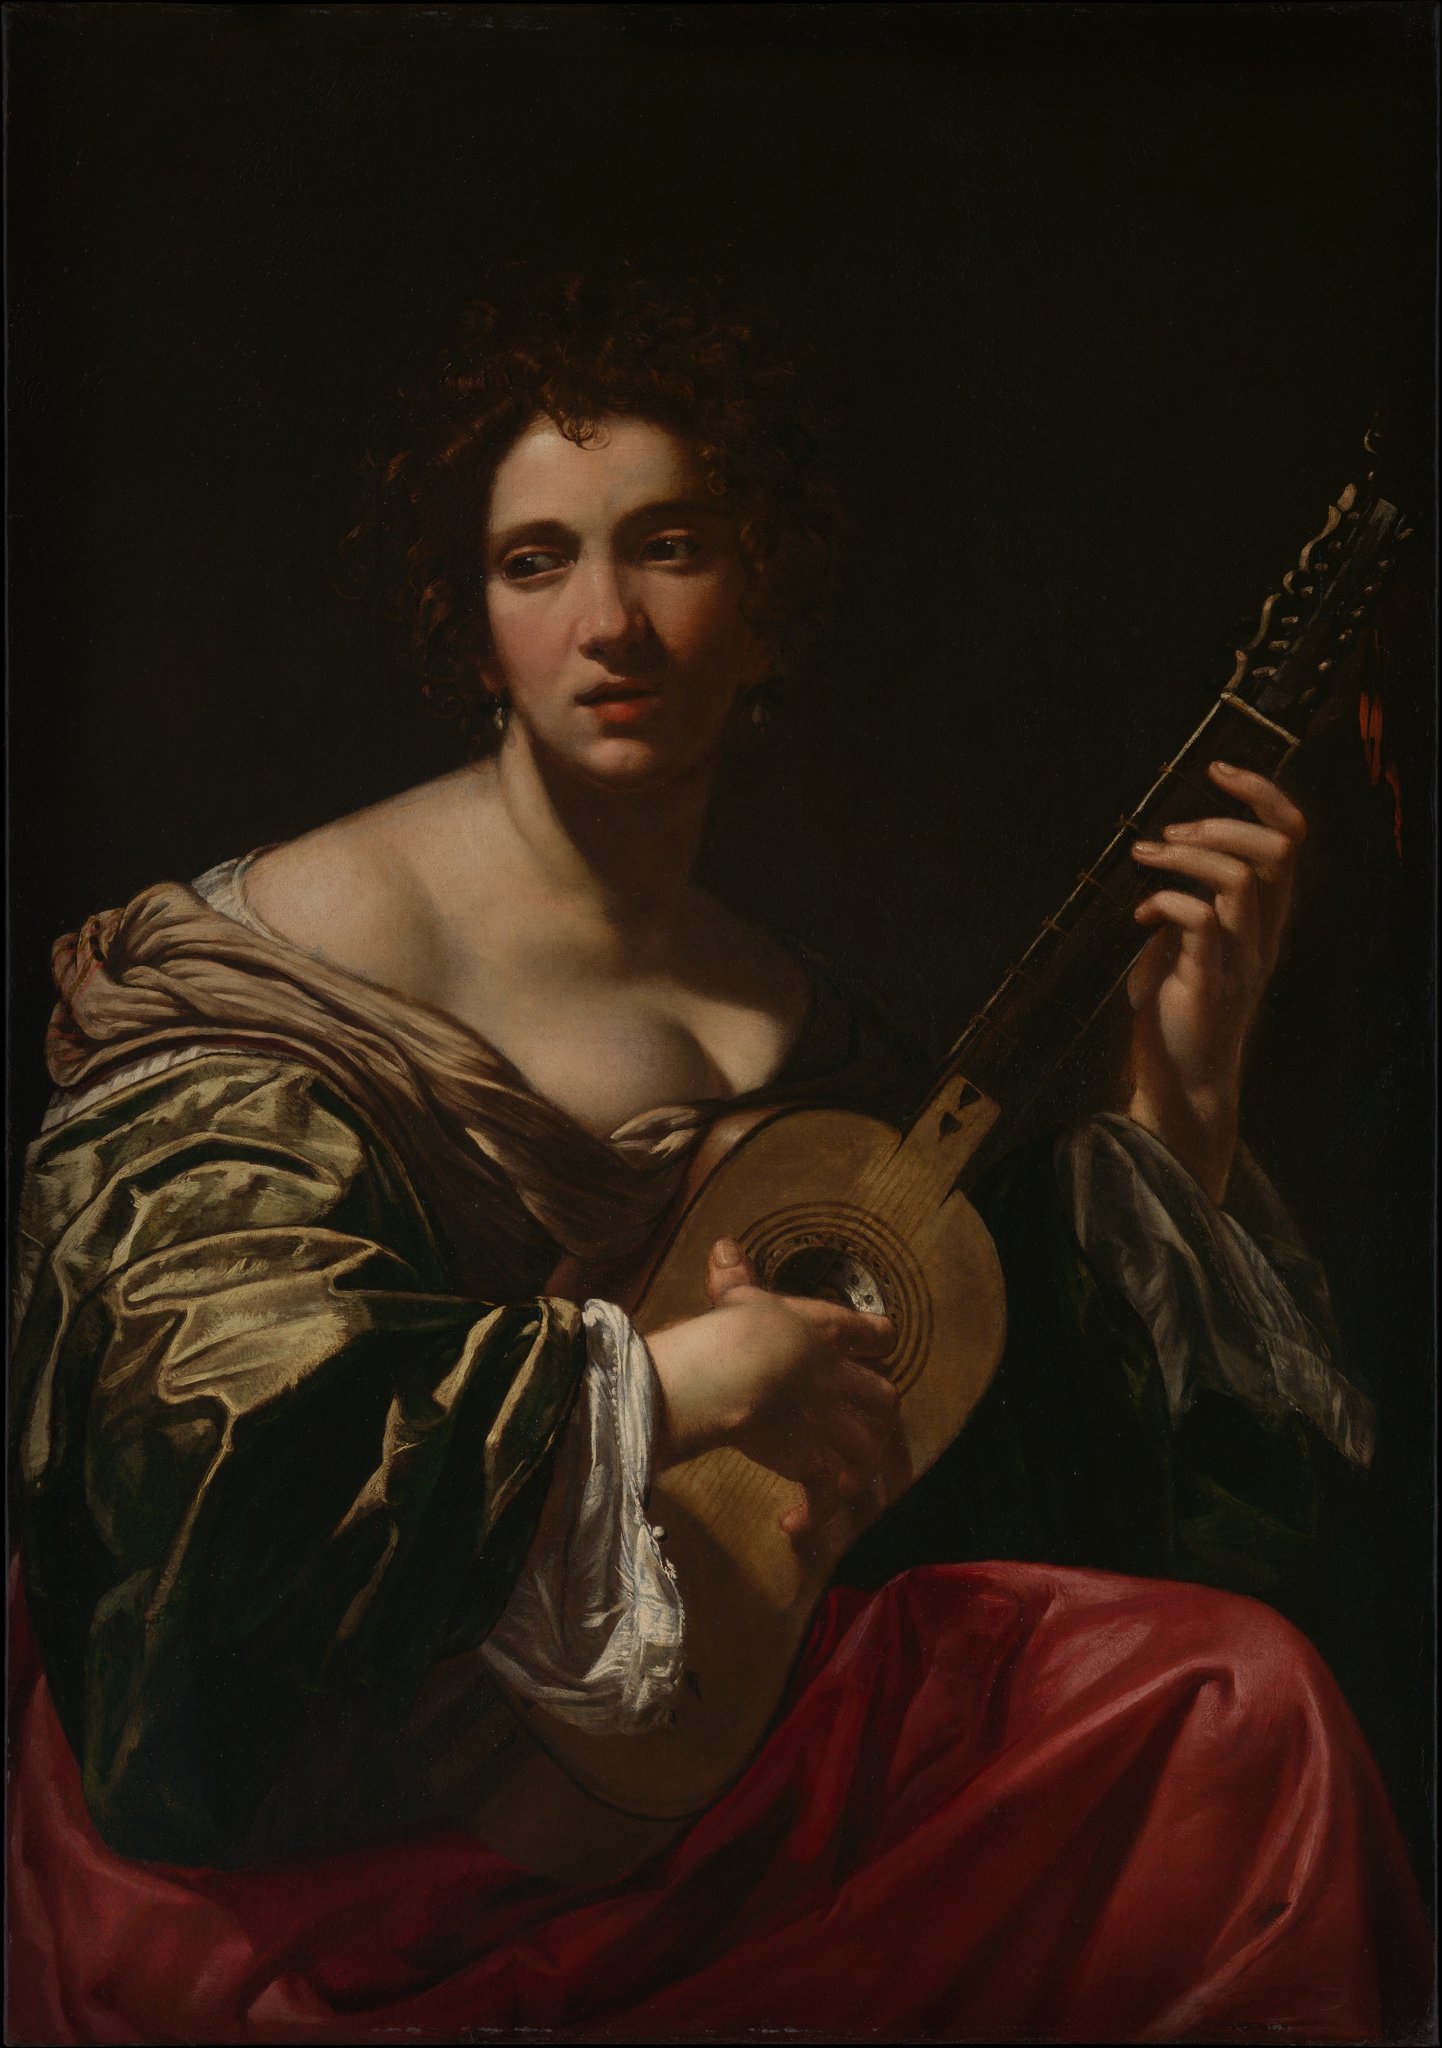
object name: painting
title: Woman Playing a Guitar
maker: simon vouet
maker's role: artist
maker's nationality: french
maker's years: 1590-1649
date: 1618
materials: canvas, oil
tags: portraits,women,guitars,musicians